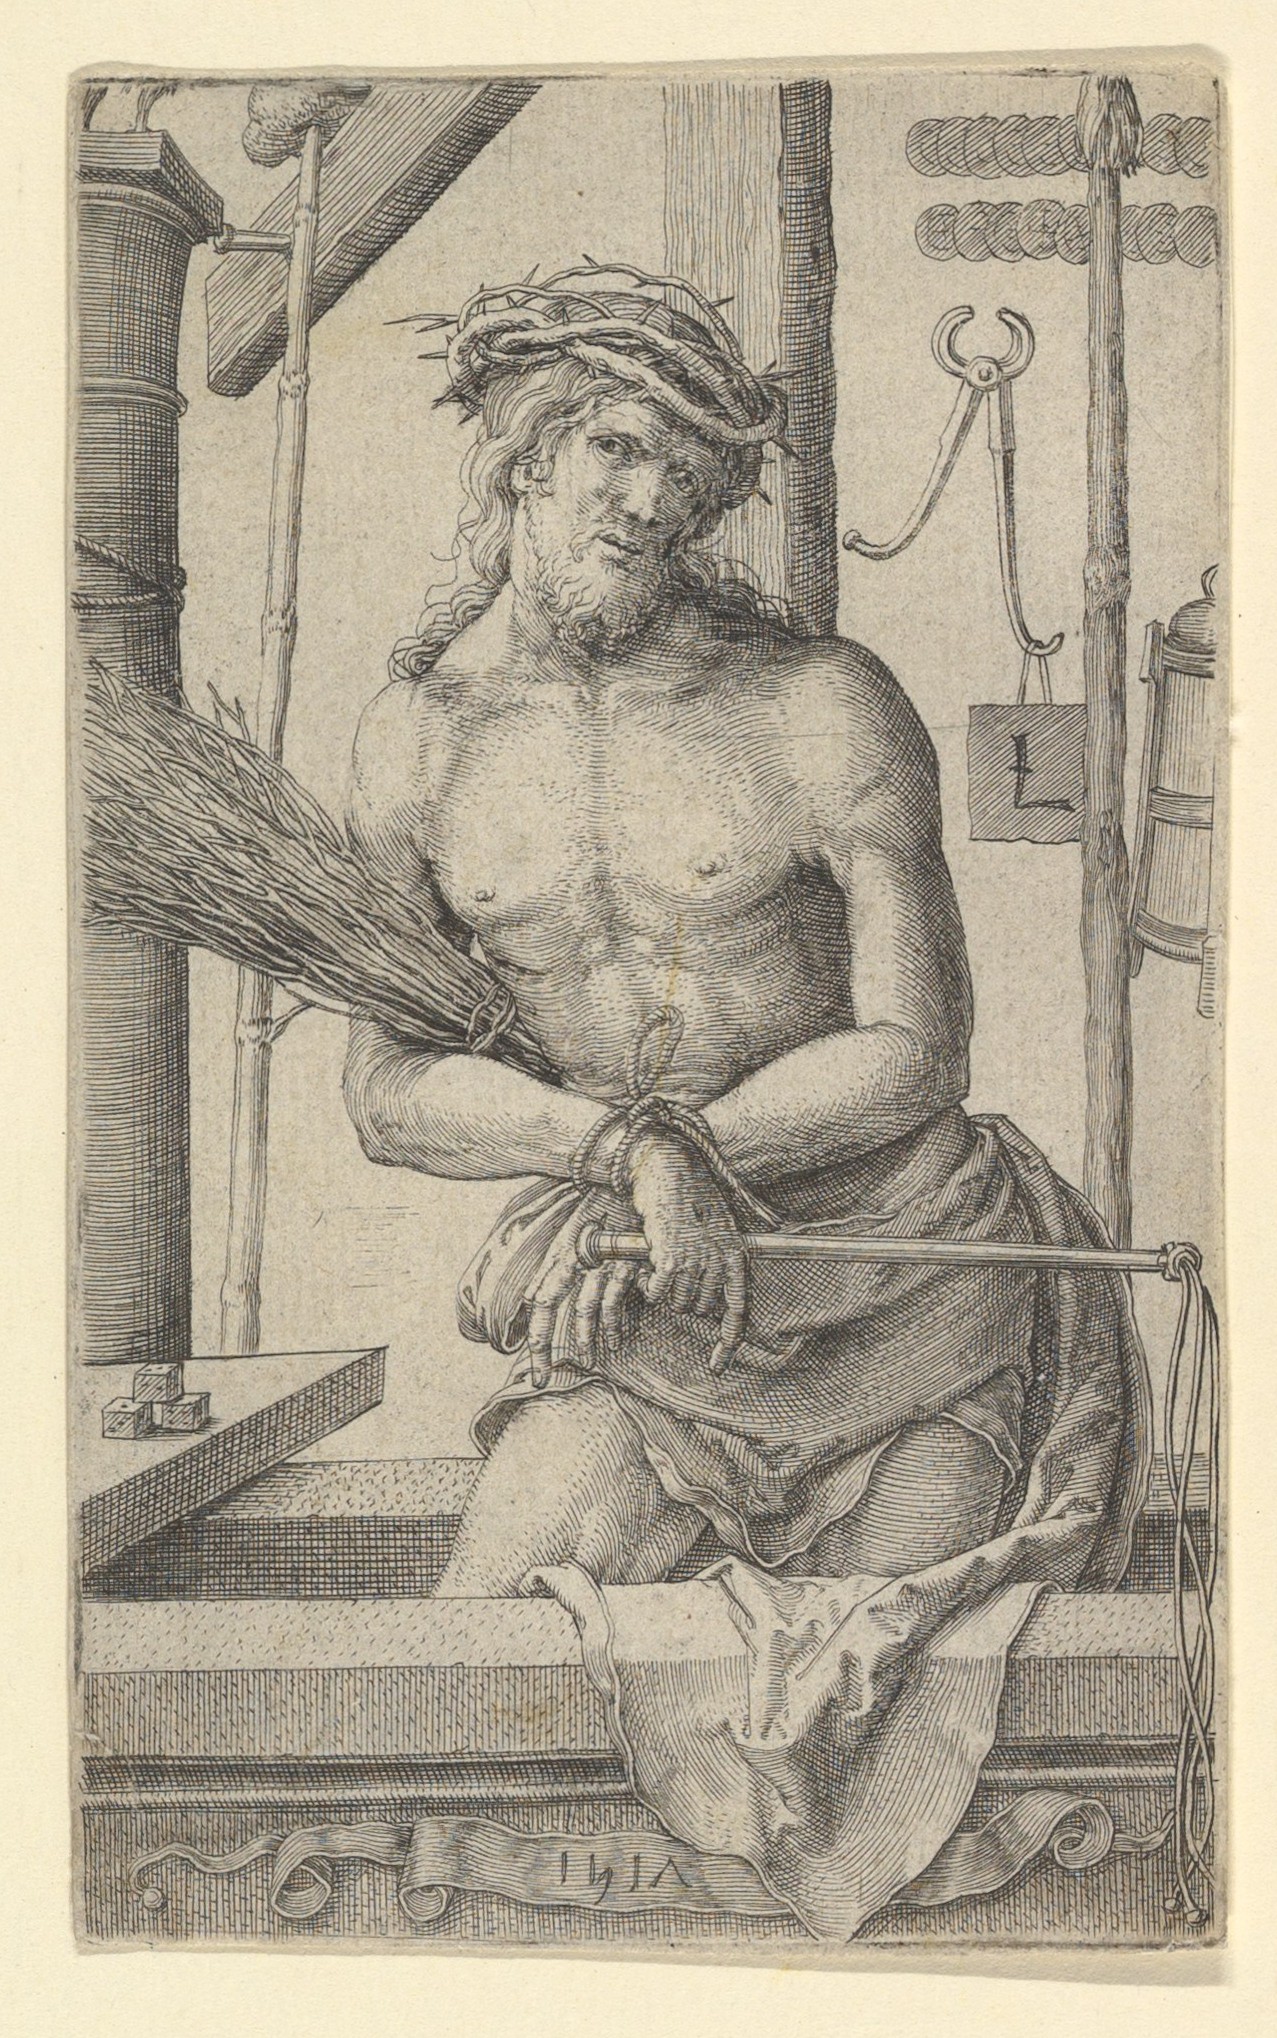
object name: print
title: Christ as the Man of Sorrows with the Instruments of the Passion.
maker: lucas van leyden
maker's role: artist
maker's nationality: netherlandish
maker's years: 1494-1533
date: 1517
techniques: engraving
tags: christ